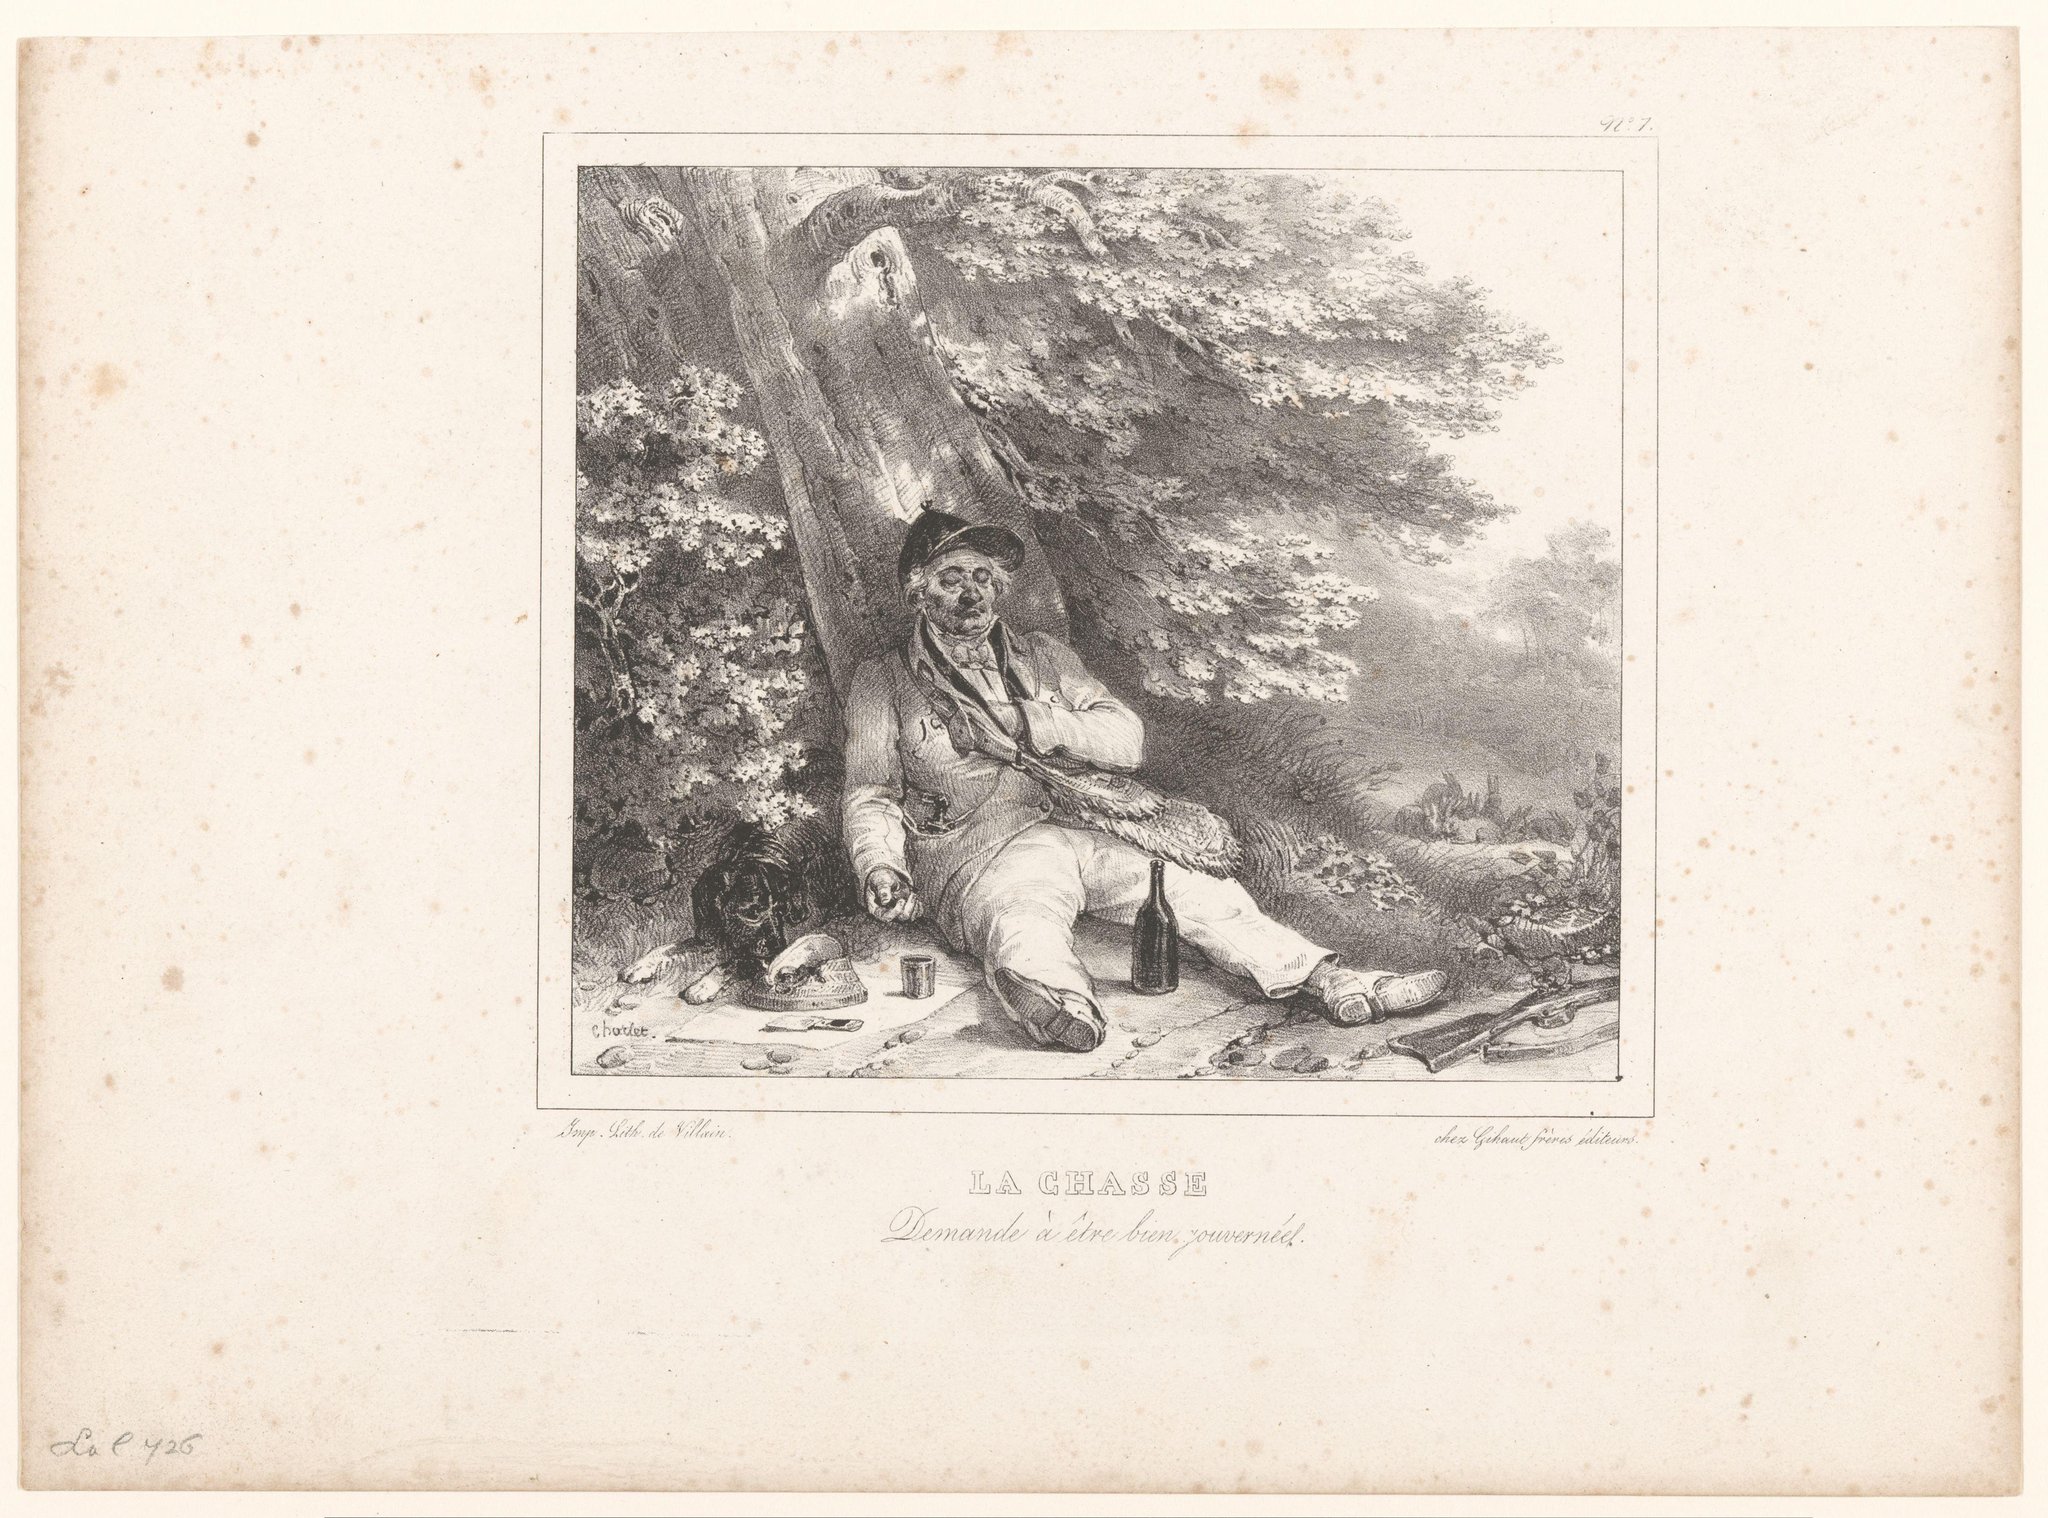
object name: print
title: Jager en hond rusten uit na de maaltijd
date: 1829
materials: paper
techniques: lithograph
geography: paris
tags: hunters resting during the hunt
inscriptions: collector's mark: Lugt 2228a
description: De licht ironische tekst stelt dat jagen een goede maaltijd vereist. Op de achtergrond loopt een groep konijnen onbekommerd rond.